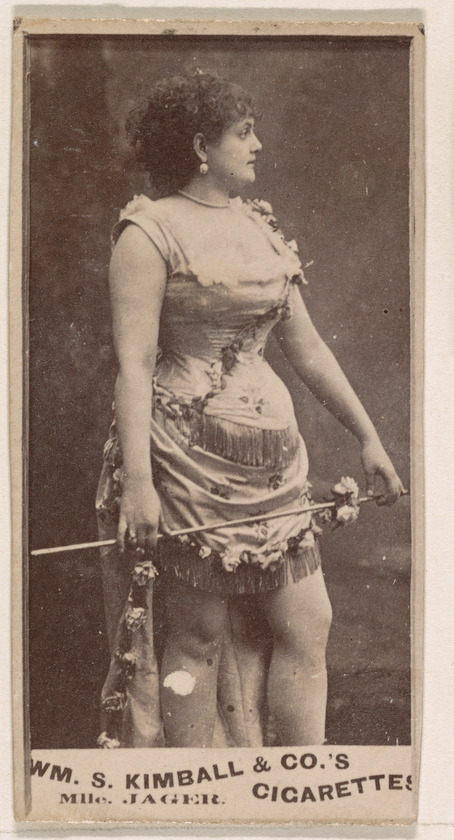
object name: photograph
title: Mlle. Jager, from the Actresses series (N203) issued by Wm. S. Kimball & Co.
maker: william s. kimball & company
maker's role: publisher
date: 1889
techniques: color lithograph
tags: portraits,women,actresses